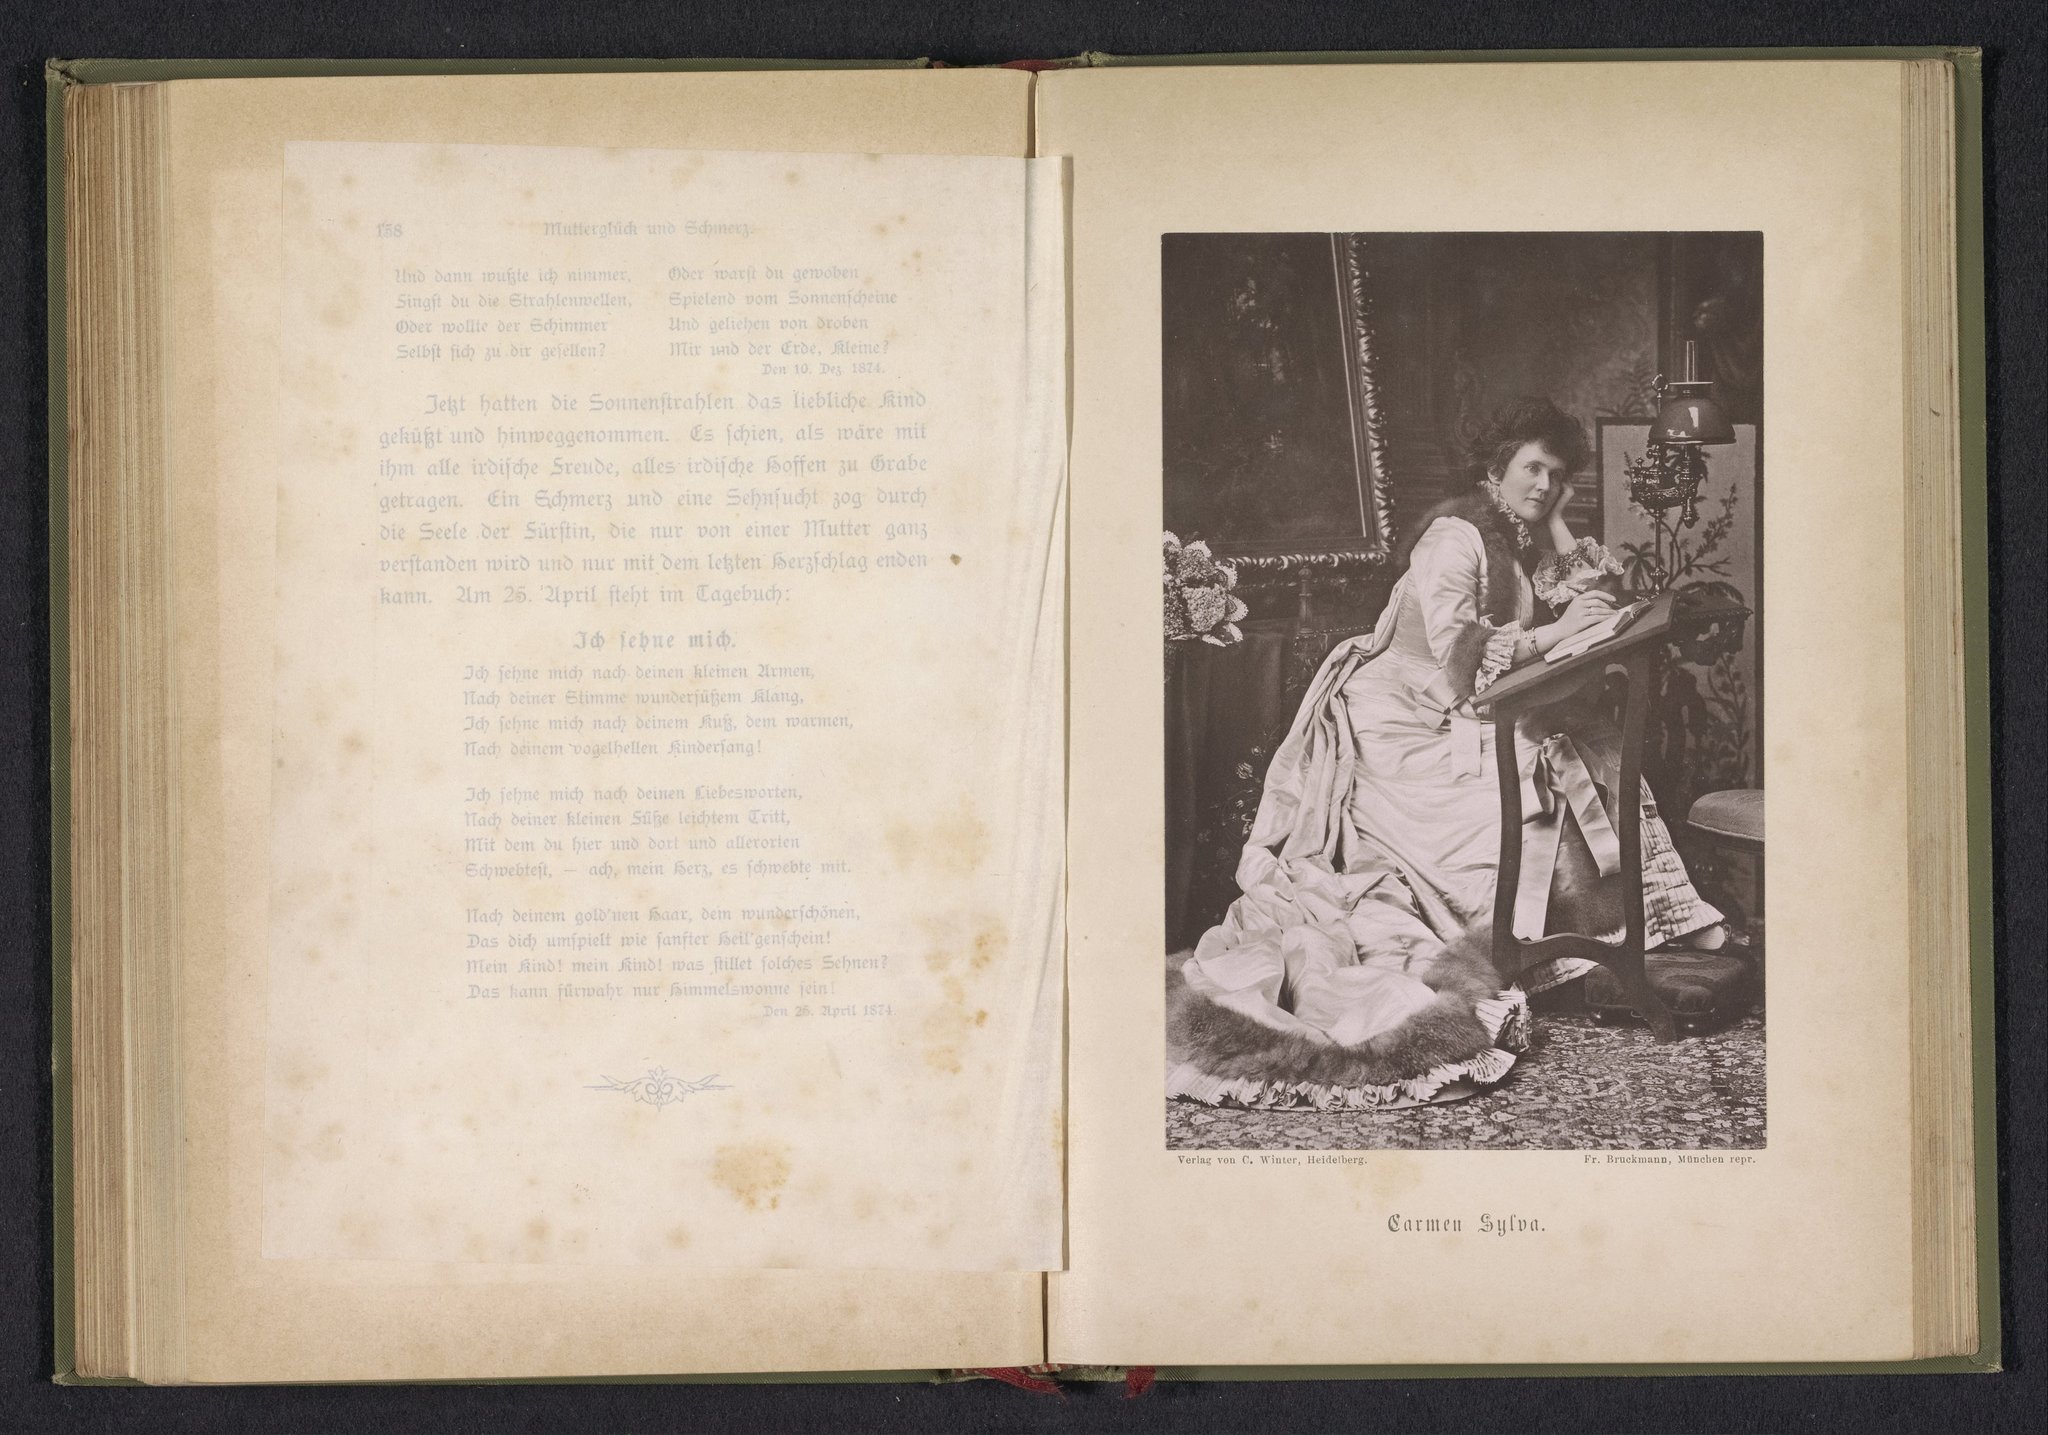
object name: page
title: Carmen Sylva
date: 1876-1886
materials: paper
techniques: photograph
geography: heidelberg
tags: portrait of a writer, ruler, sovereign - bb - female ruler